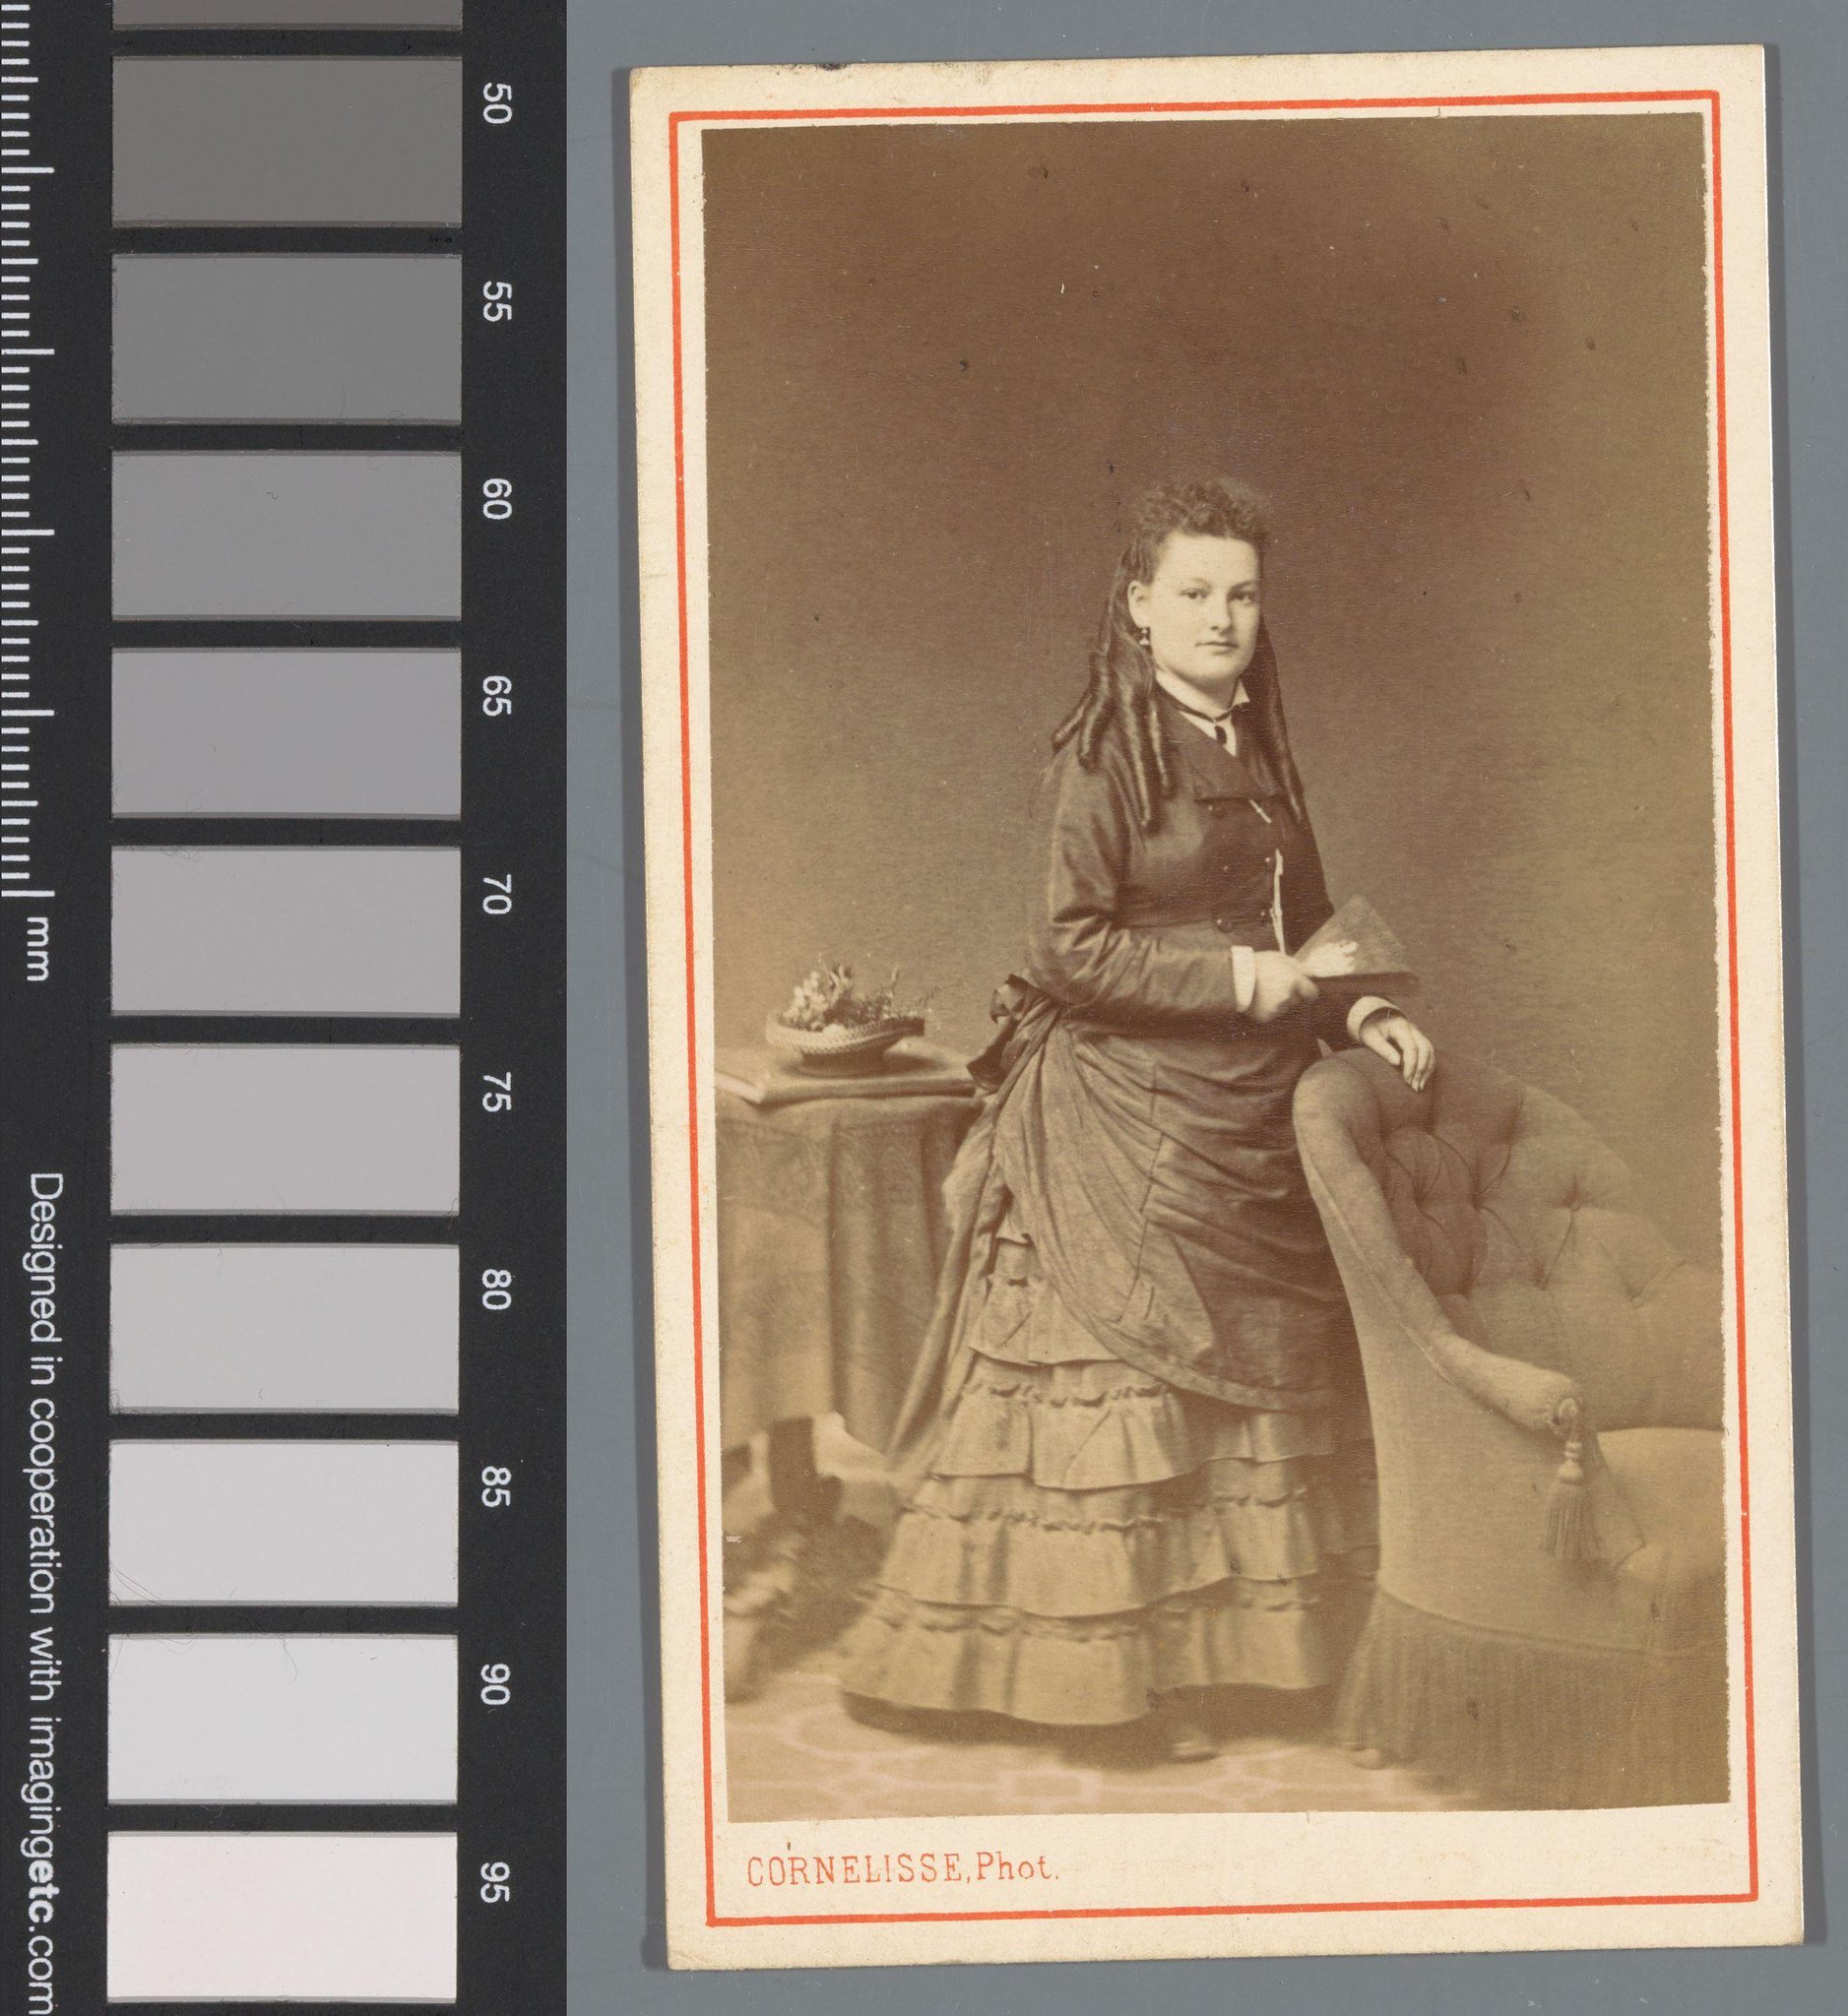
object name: carte de visite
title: Portret van een onbekende jonge vrouw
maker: e. cornelisse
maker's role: fotograaf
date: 1863-1875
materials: cardboard, paper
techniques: albumen print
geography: brussels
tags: adolescent, young woman, maiden, anonymous historical person portrayed, brussels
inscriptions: inscription: ‘Cornelisse, phot.’, inscription: ‘Cornelisse/ Bruxelles, Rue Neuve, 22./ Rotterdam, Wagestraat./ English Spoken/Les Clichés étant conservés indéfiniment/ on peut toujours obtenir de nouvelles épreuves/ sans poser de nouveau.’